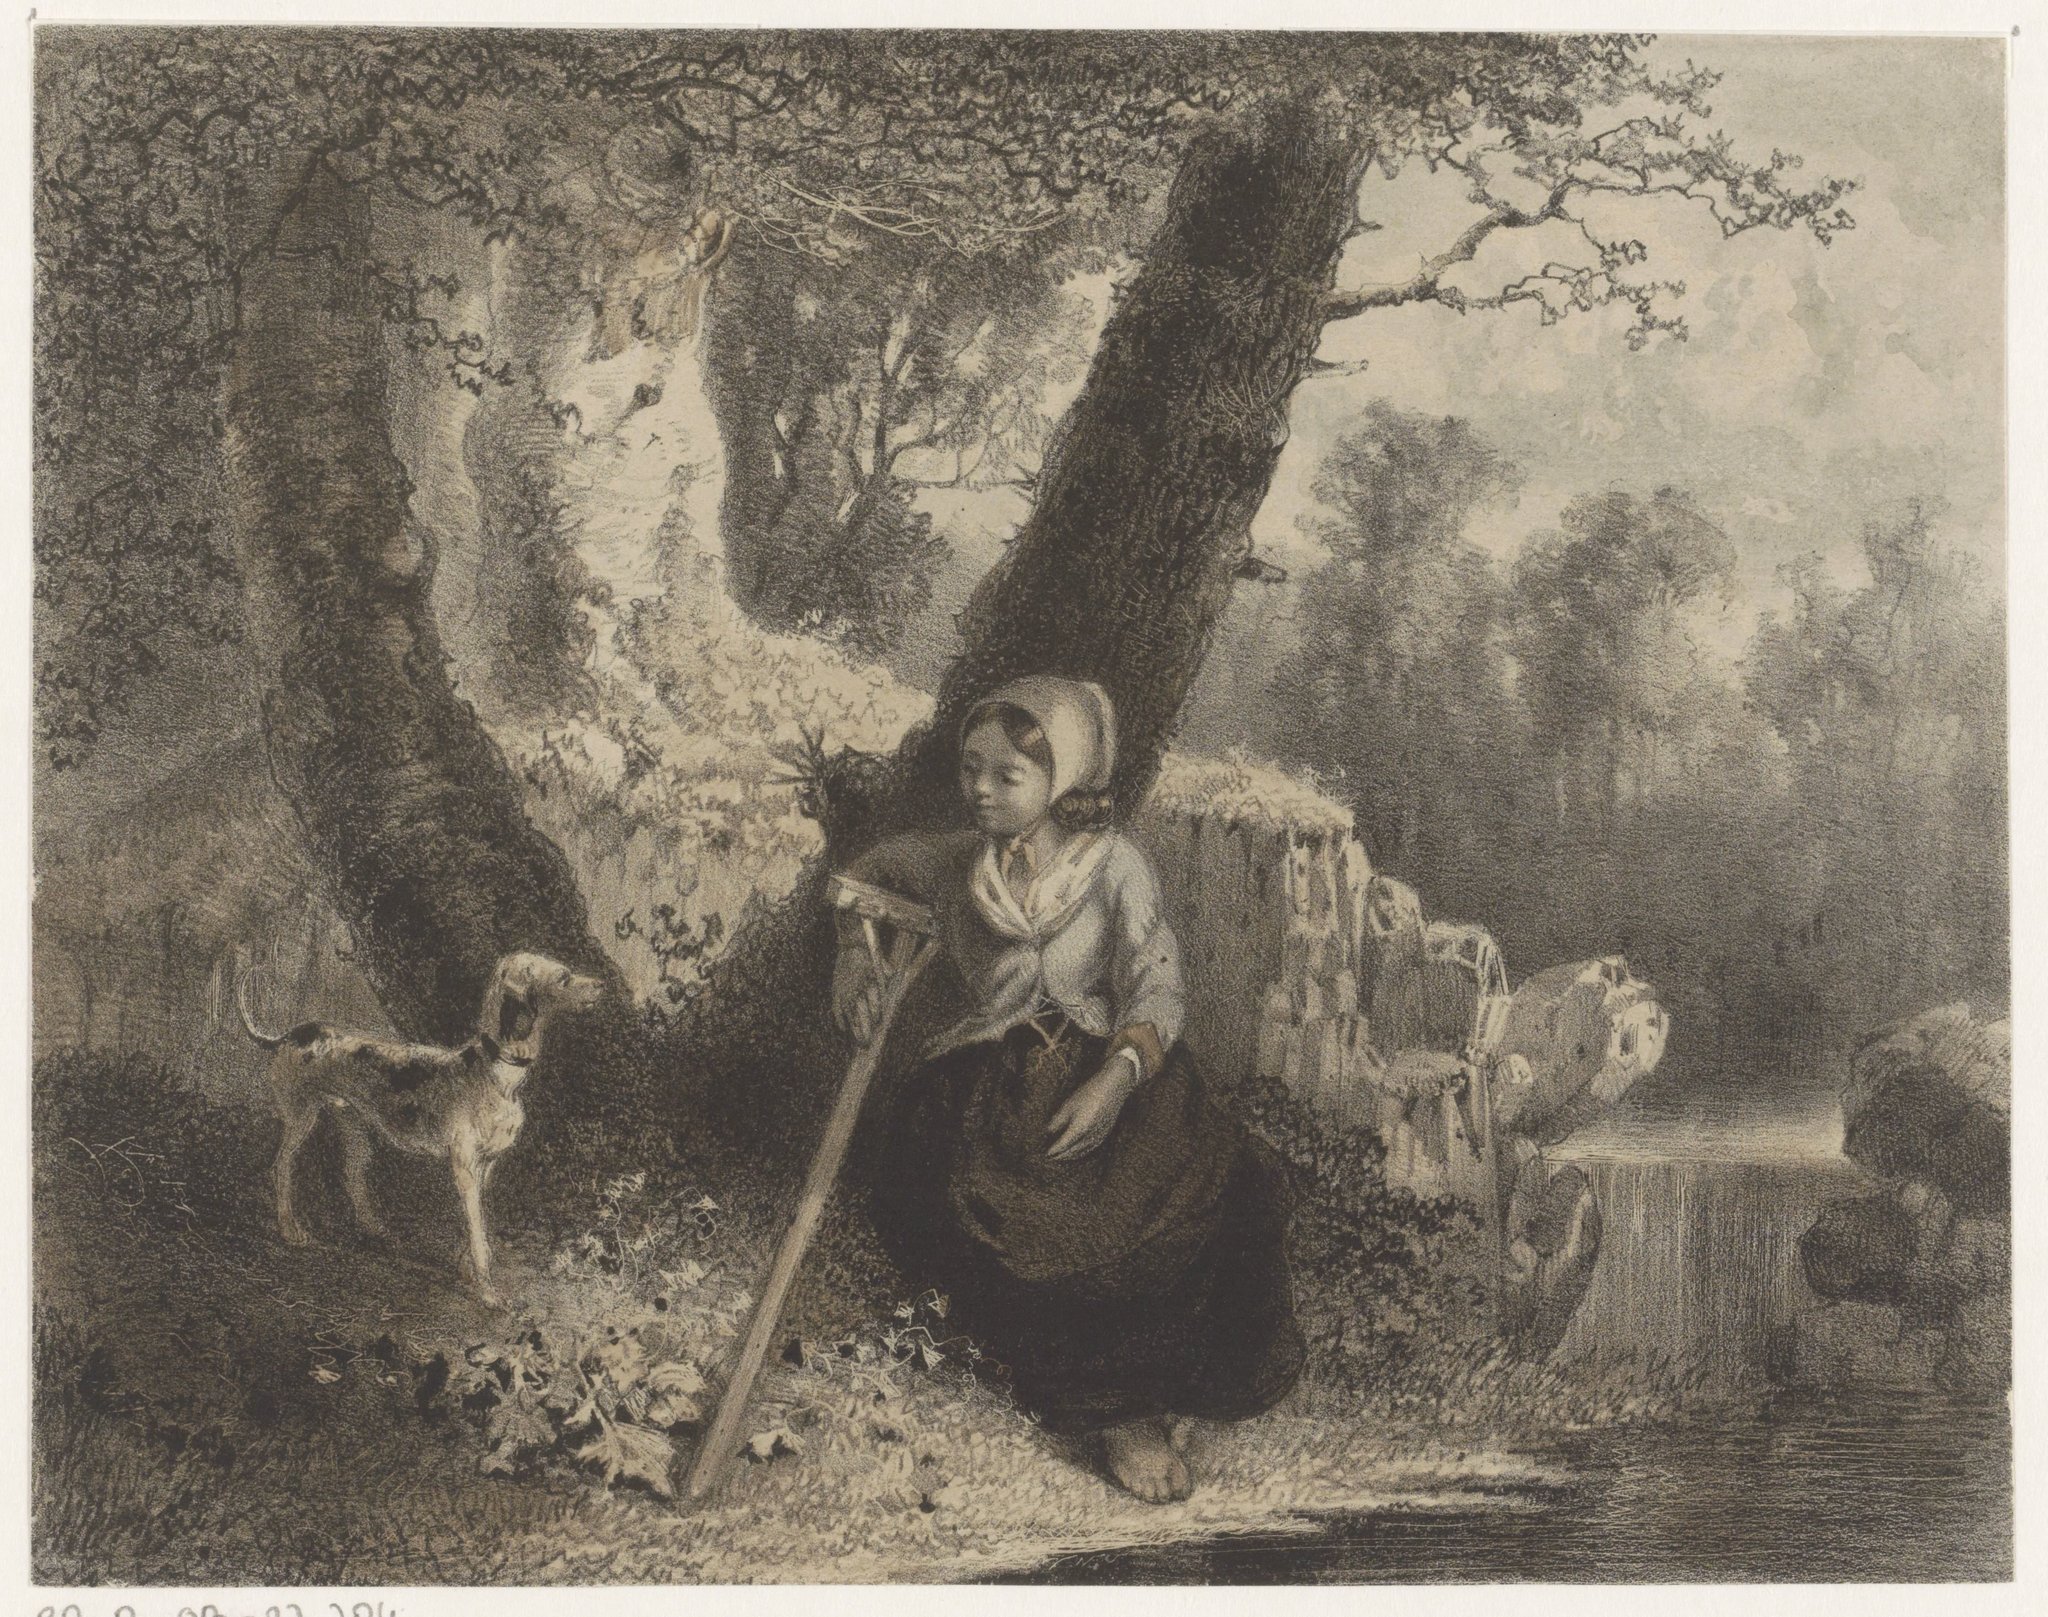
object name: print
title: Meisje steunend op een kruk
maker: richard burnier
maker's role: print maker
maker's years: 1826-1884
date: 1835-1884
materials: paper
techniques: tone lithography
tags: crutches - aa - female human figure, brook, dog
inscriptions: inscription: ‘R. Burnier door hem zelve gewassen’, collector's mark: Lugt 2228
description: Het meisje zit in een bosrijk landschap aan een beek met een kleine waterval. Ze heeft een kruk onder haar linker oksel en kijkt naar een hond links van haar.